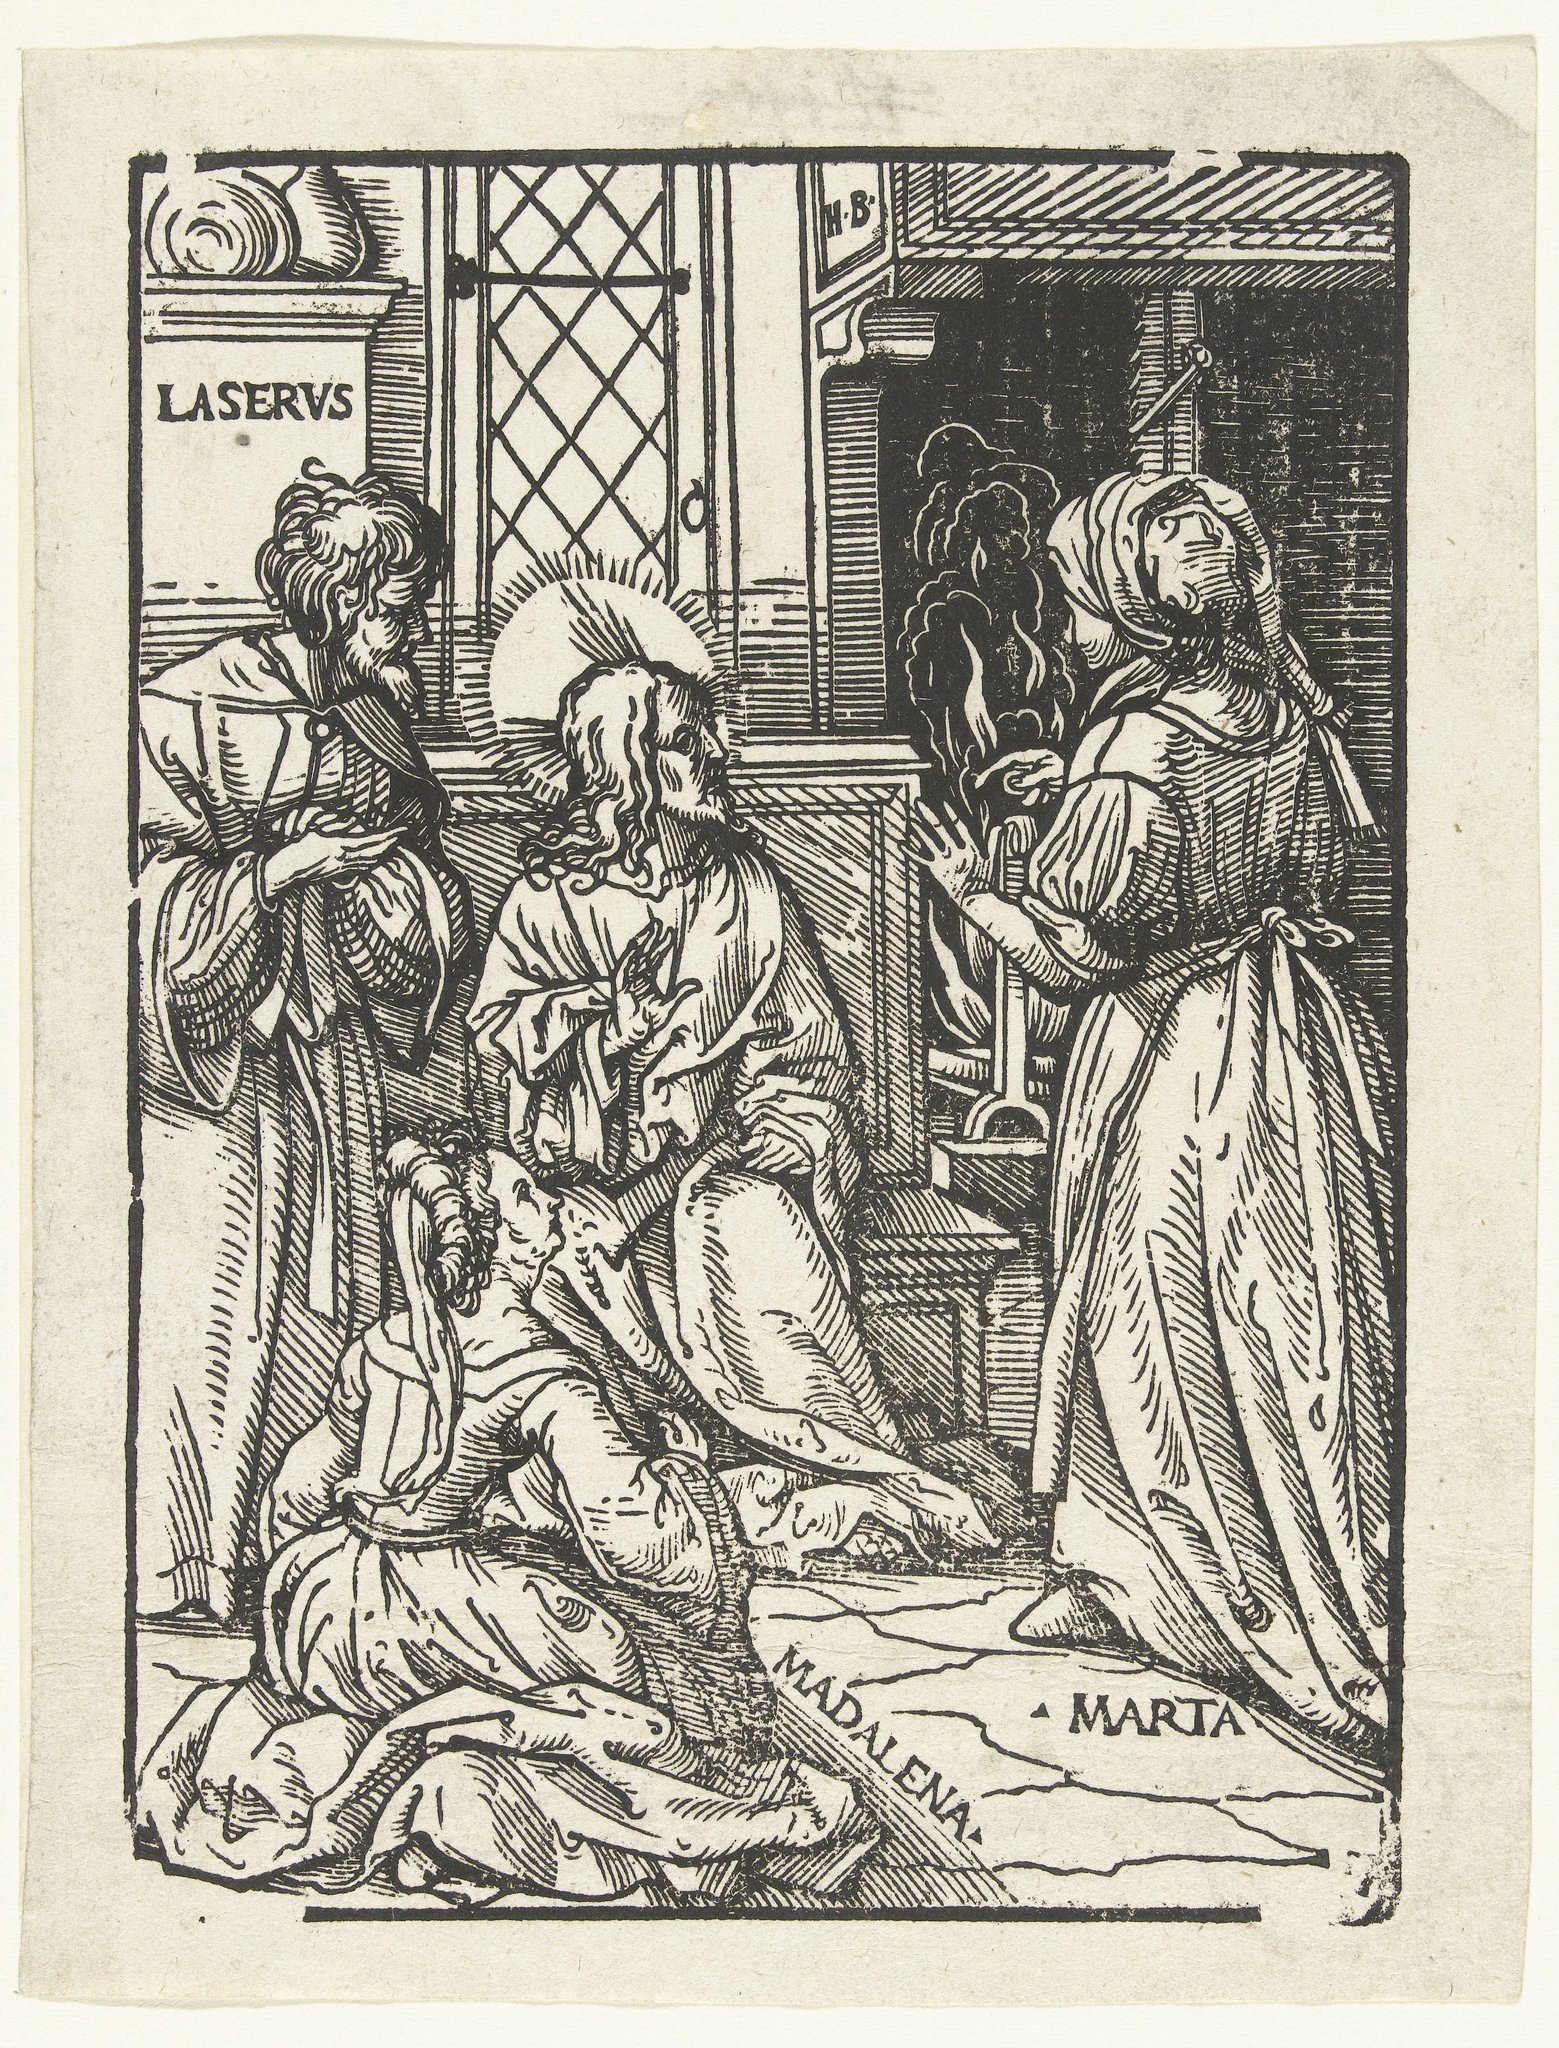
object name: print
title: Christus in het huis van Marta en Maria Magdalena en Lazarus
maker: hans burgkmair (i)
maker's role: draughtsman, print maker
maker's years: 1473-1531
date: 1483-1510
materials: paper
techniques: woodcut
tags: christ's answer to martha who complains about mary: 'mary has chosen the good portion ...'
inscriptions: collector's mark: Lugt 240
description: Christus zit in het huis van Marta en is in gesprek met Marta, haar zus Maria Magdalena zit aandachtig luisterend op de grond en haar broer Lazarus staat naast Christus. De namen van de laatste drie staan bij de figuren. Op de achtergrond rechts brandt een openhaard.